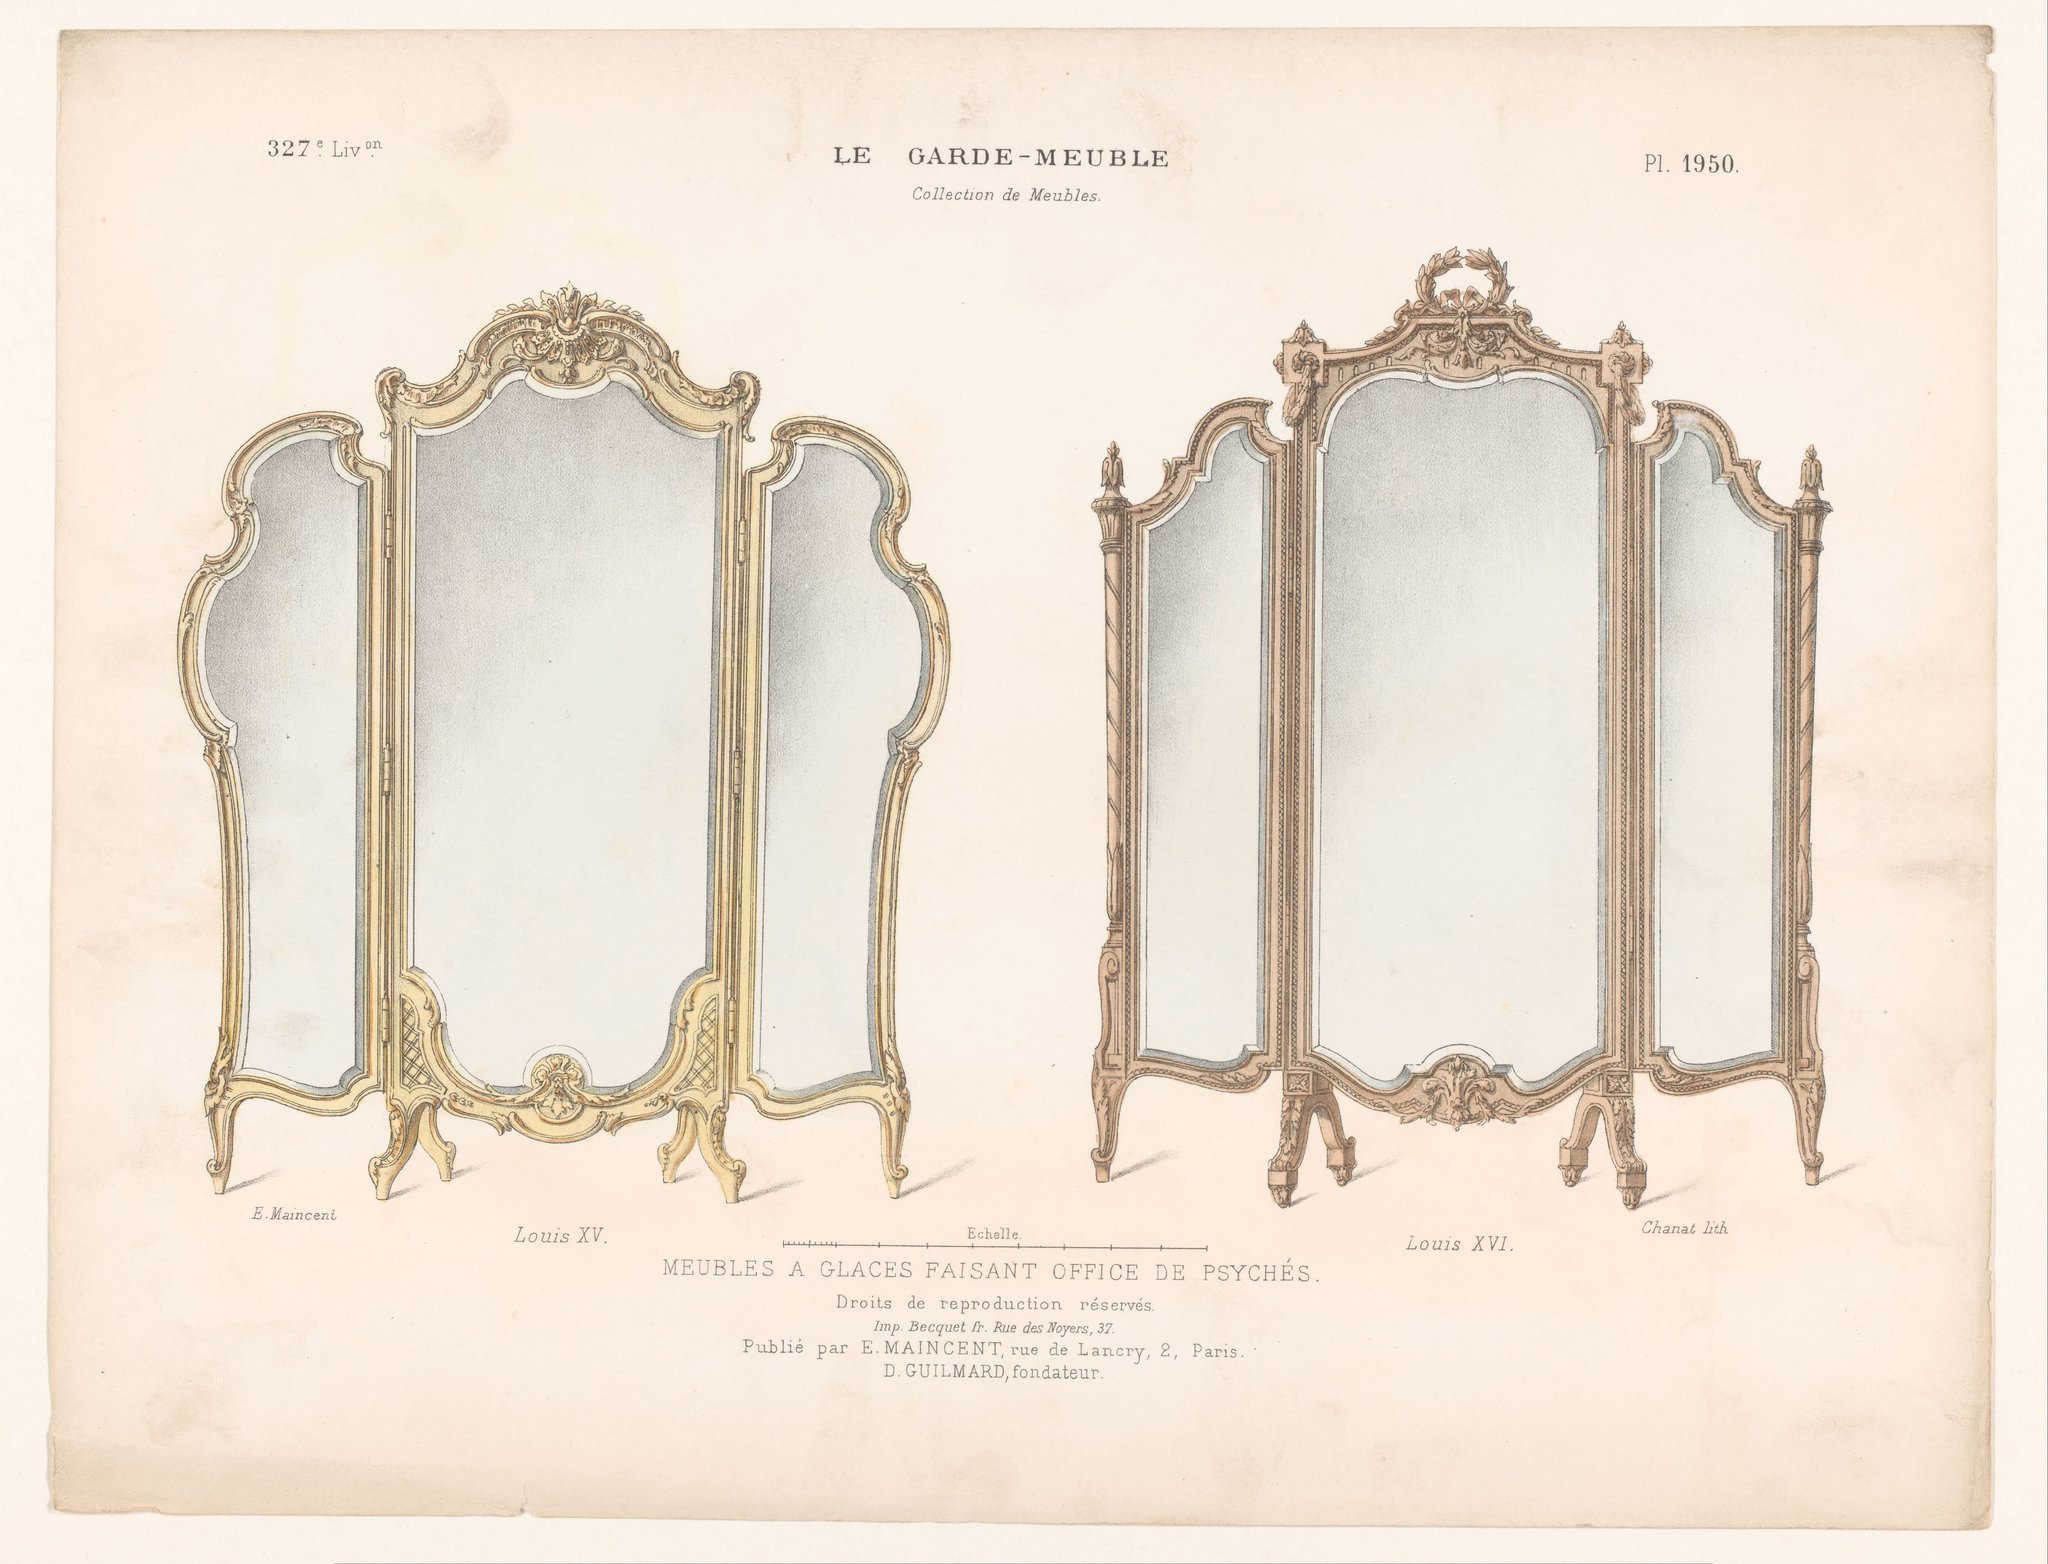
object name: print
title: Le garde-meuble / Collection de Meubles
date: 1885-1895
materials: paper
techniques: hand coloring, lithograph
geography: paris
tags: mirror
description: Ieder Livraison in de serie Le Garde-Meuble bevat negen platen: drie 'sièges' (zitmeubels), drie 'meubles' (diverse meubels zoals tafels en kasten) en drie 'tentures' (gordijnen en draperieën).